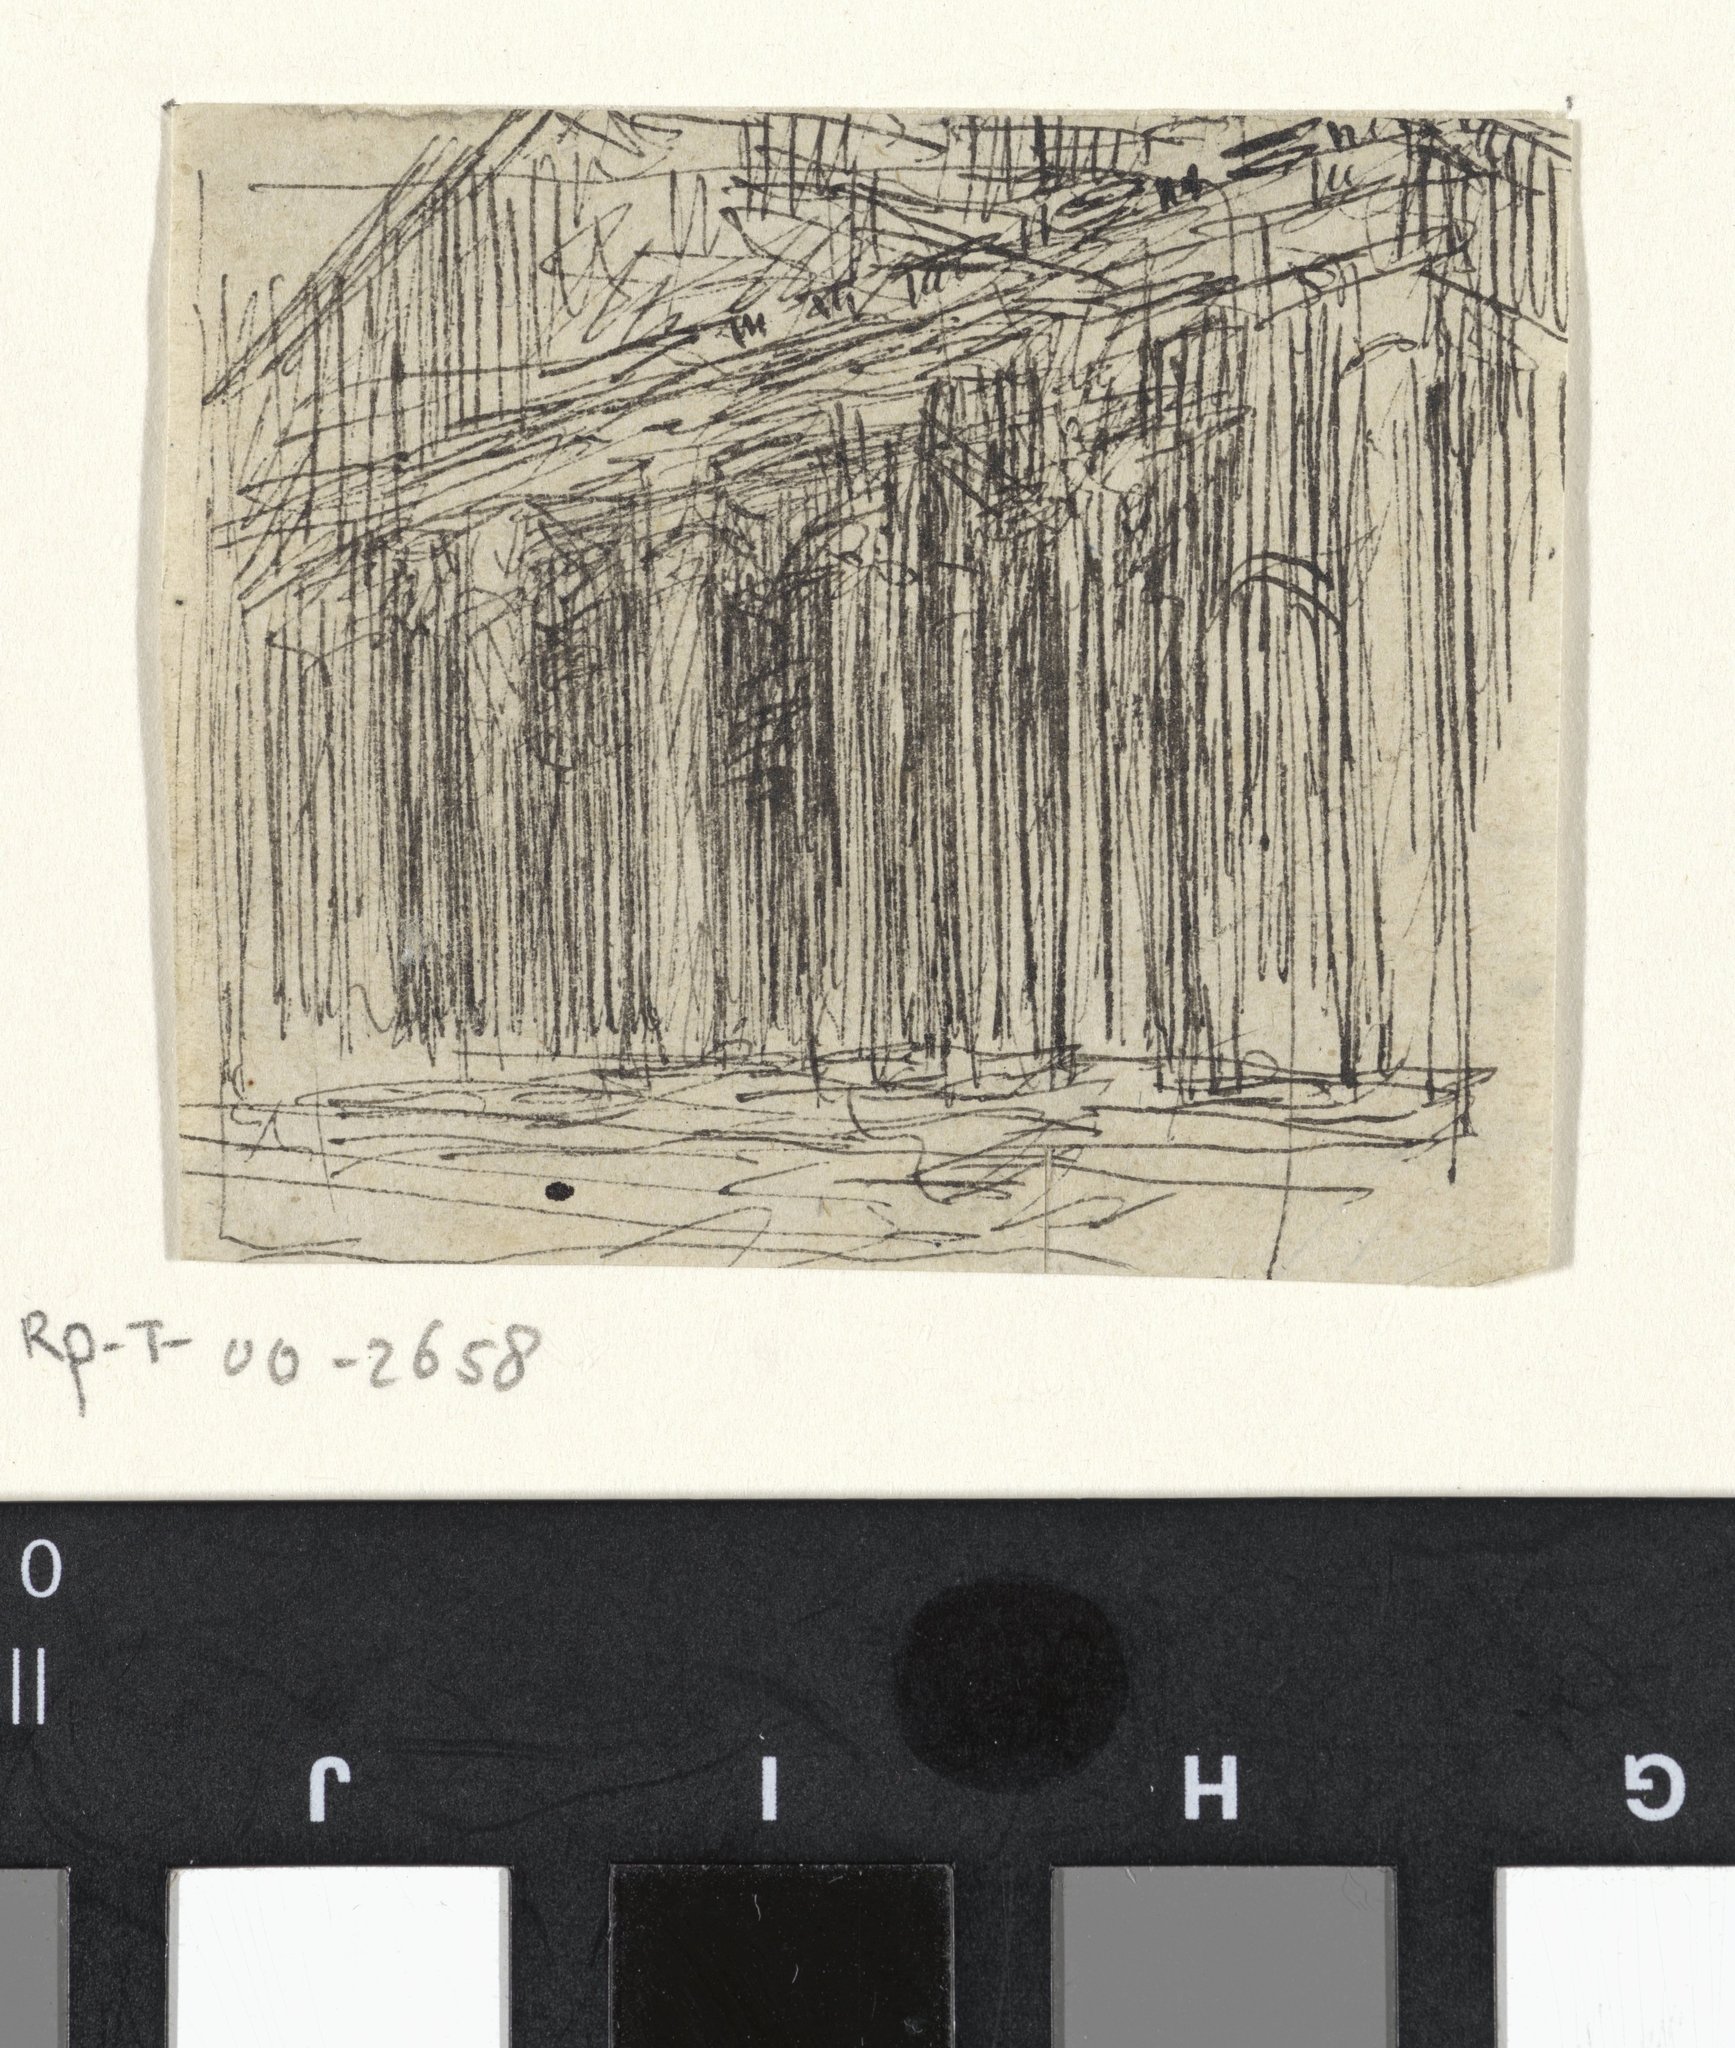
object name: drawing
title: Het Pantheon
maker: thomas cool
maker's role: draughtsman, painter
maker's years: 1851-1904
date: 1861-1904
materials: ink, paper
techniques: pen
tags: city-view, and landscape with man-made constructions, temple, shrine ~ non-christian religions